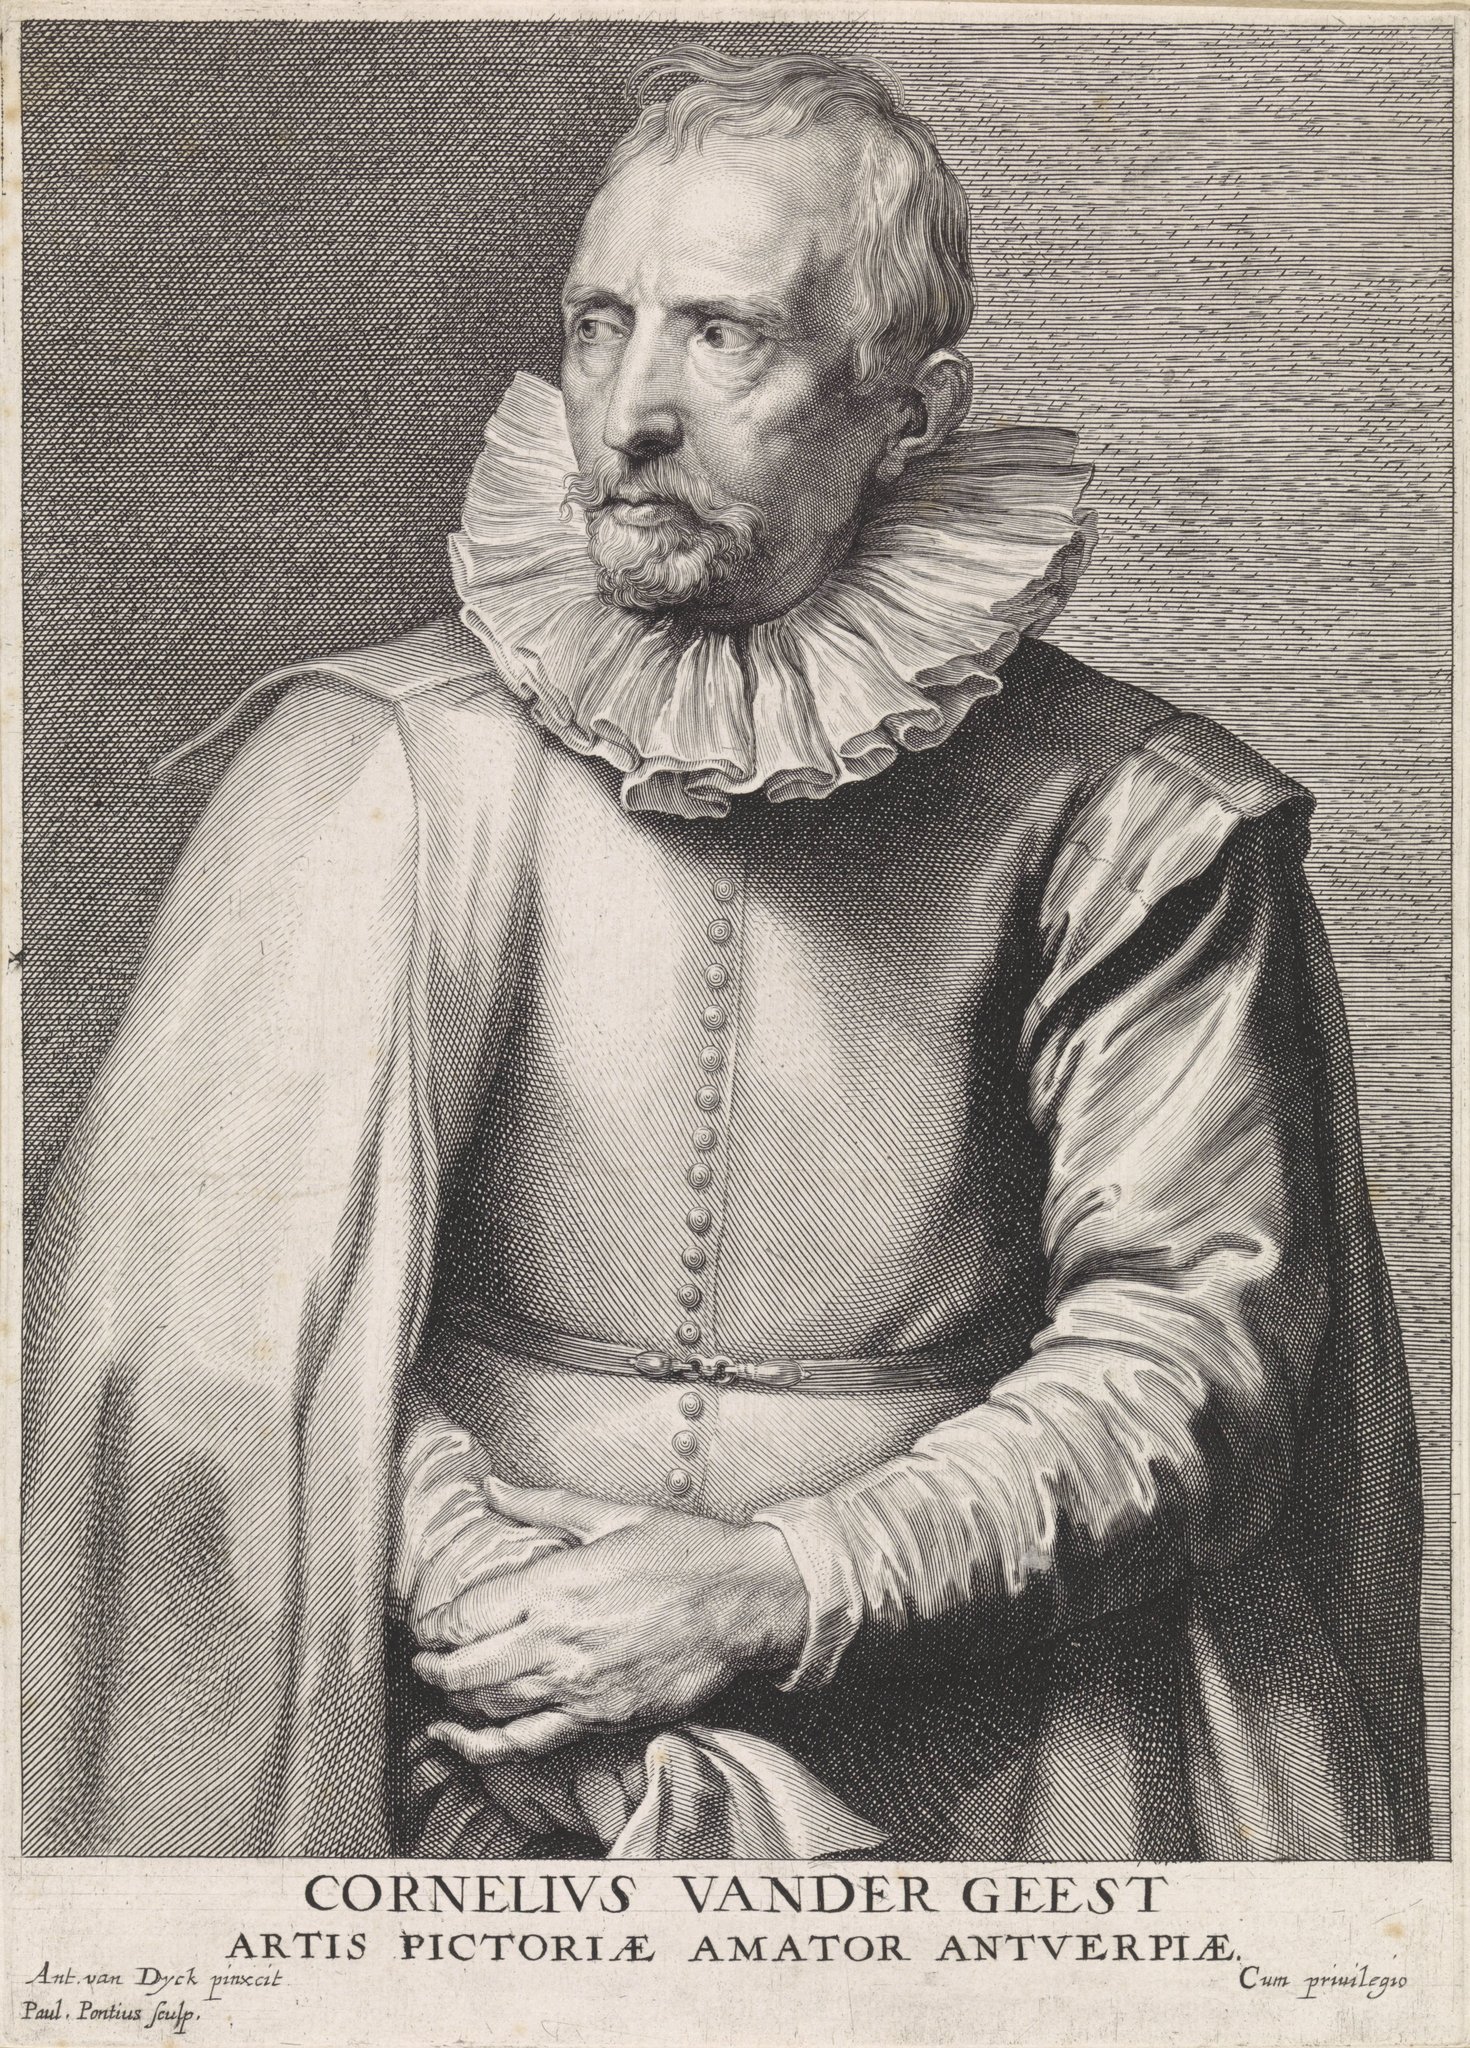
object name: print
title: Portret van Cornelis van der Geest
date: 1616-1657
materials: paper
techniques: engraving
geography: antwerp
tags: cornelis van der geest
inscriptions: collector's mark: Lugt 240